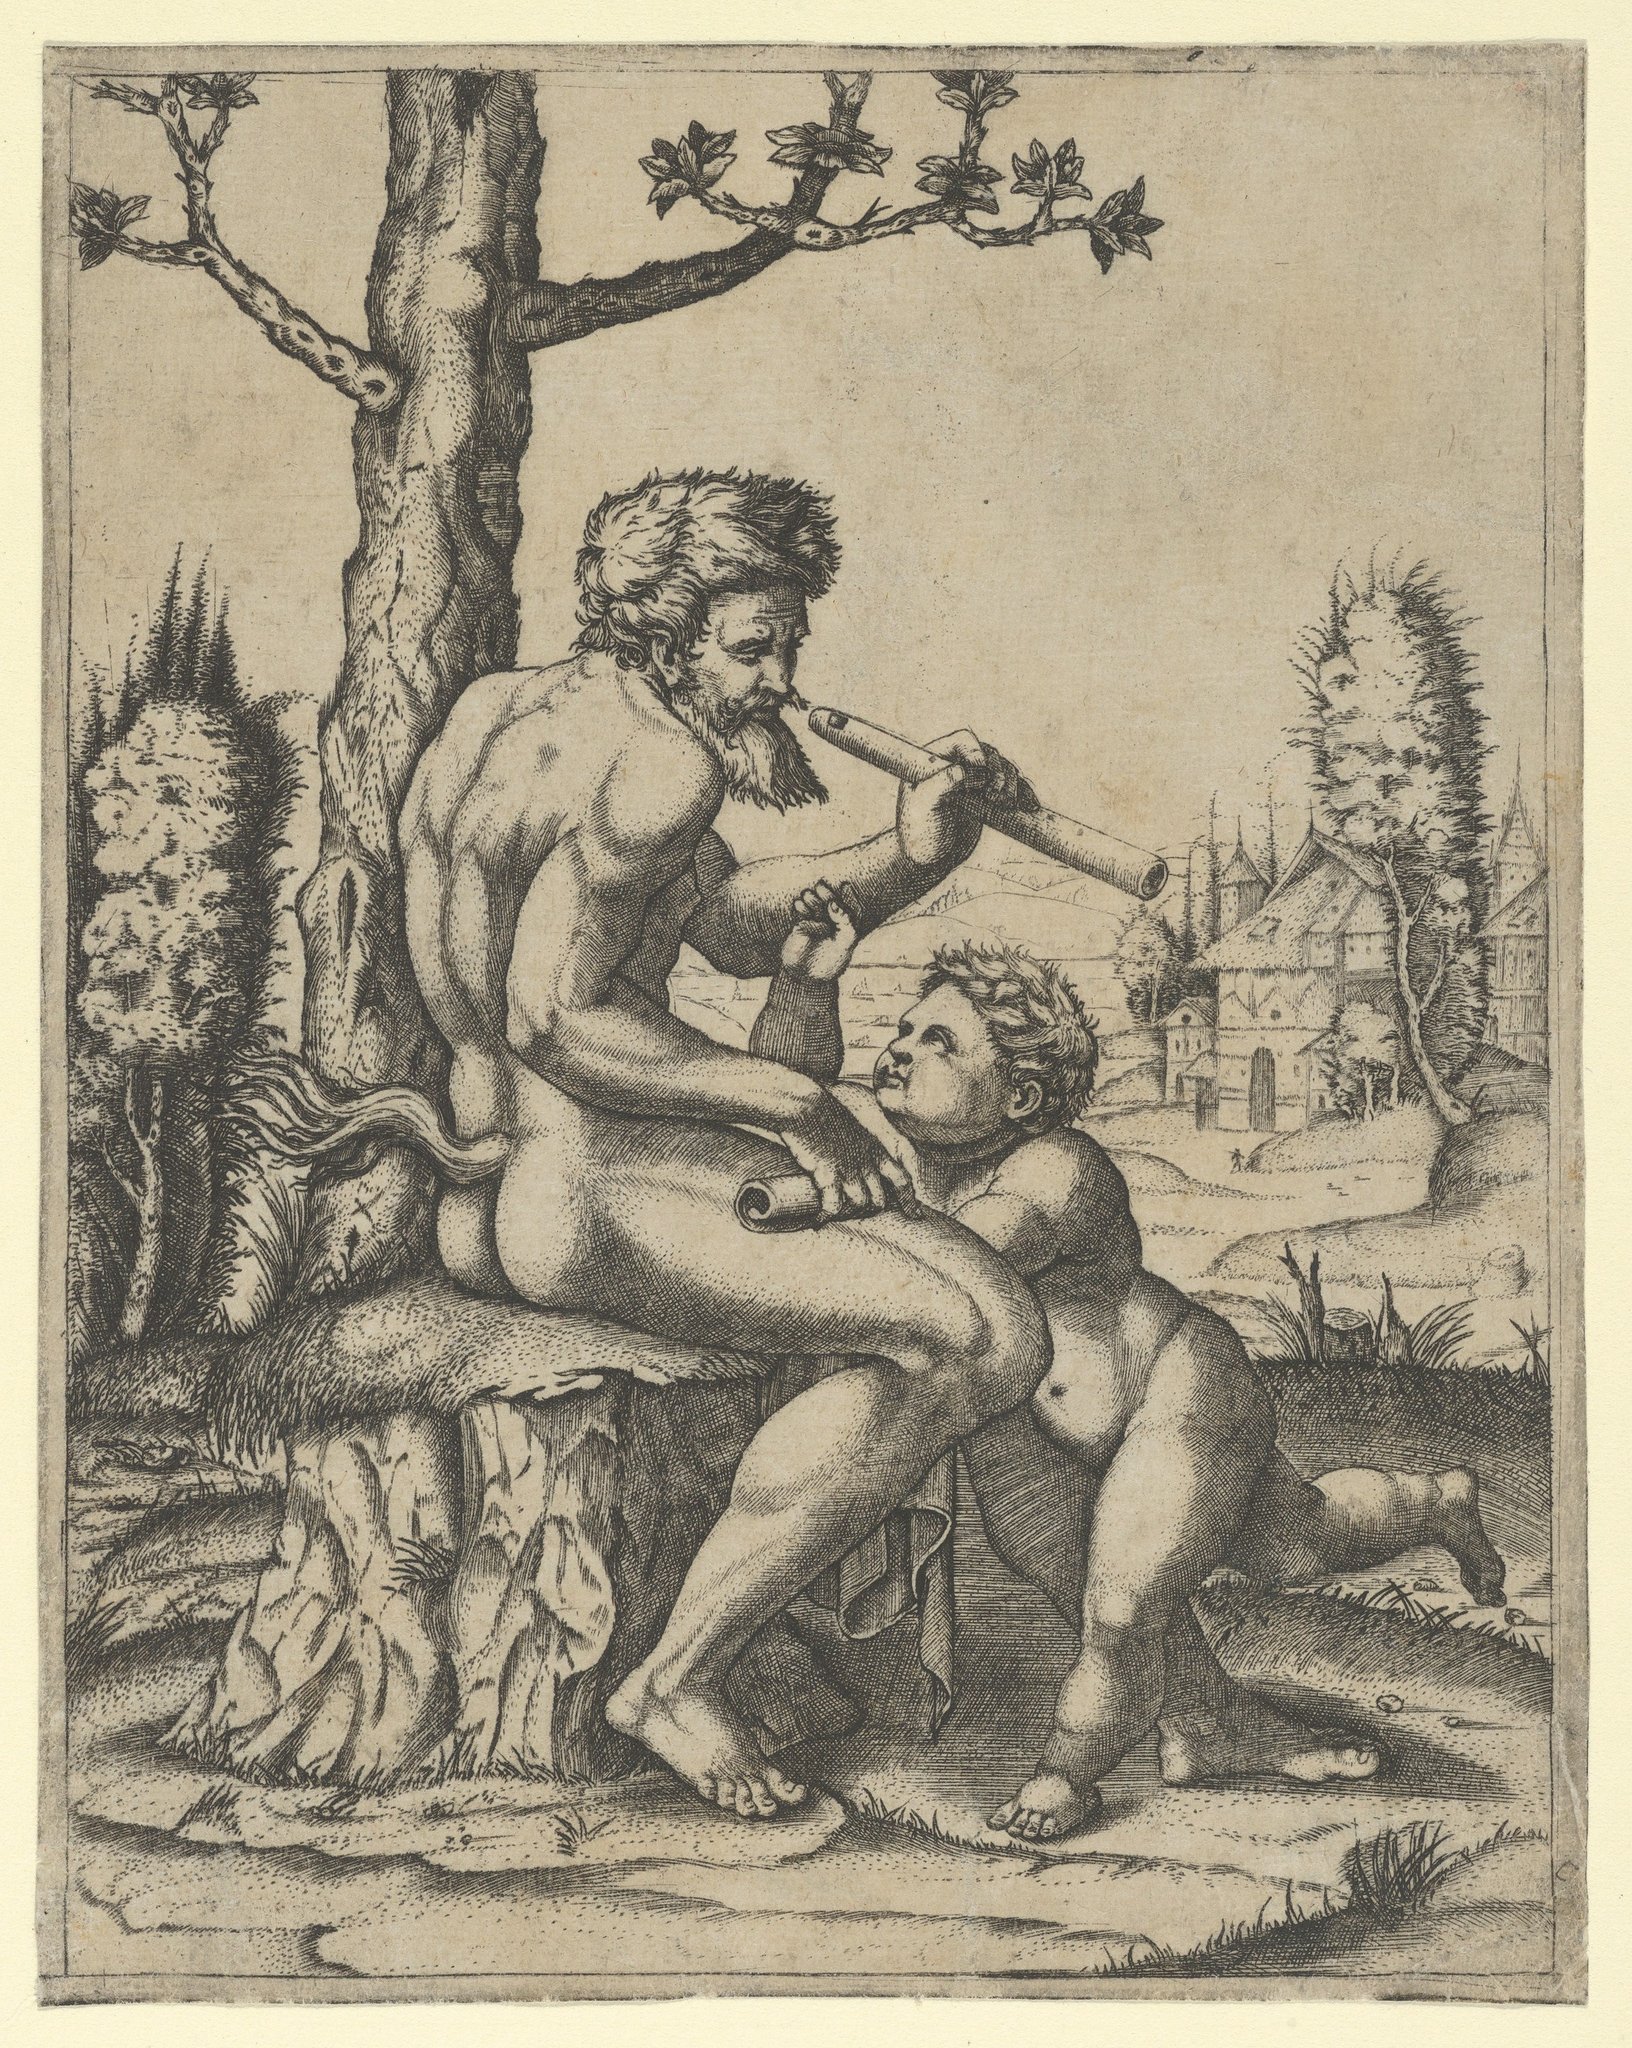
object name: print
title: A faun sitting on a rock holding a flute in his left hand; a child stands between his knees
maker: marcantonio raimondi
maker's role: artist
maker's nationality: italian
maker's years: 1475-1534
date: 1510-1527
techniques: engraving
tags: houses,children,flutes,fauns,trees